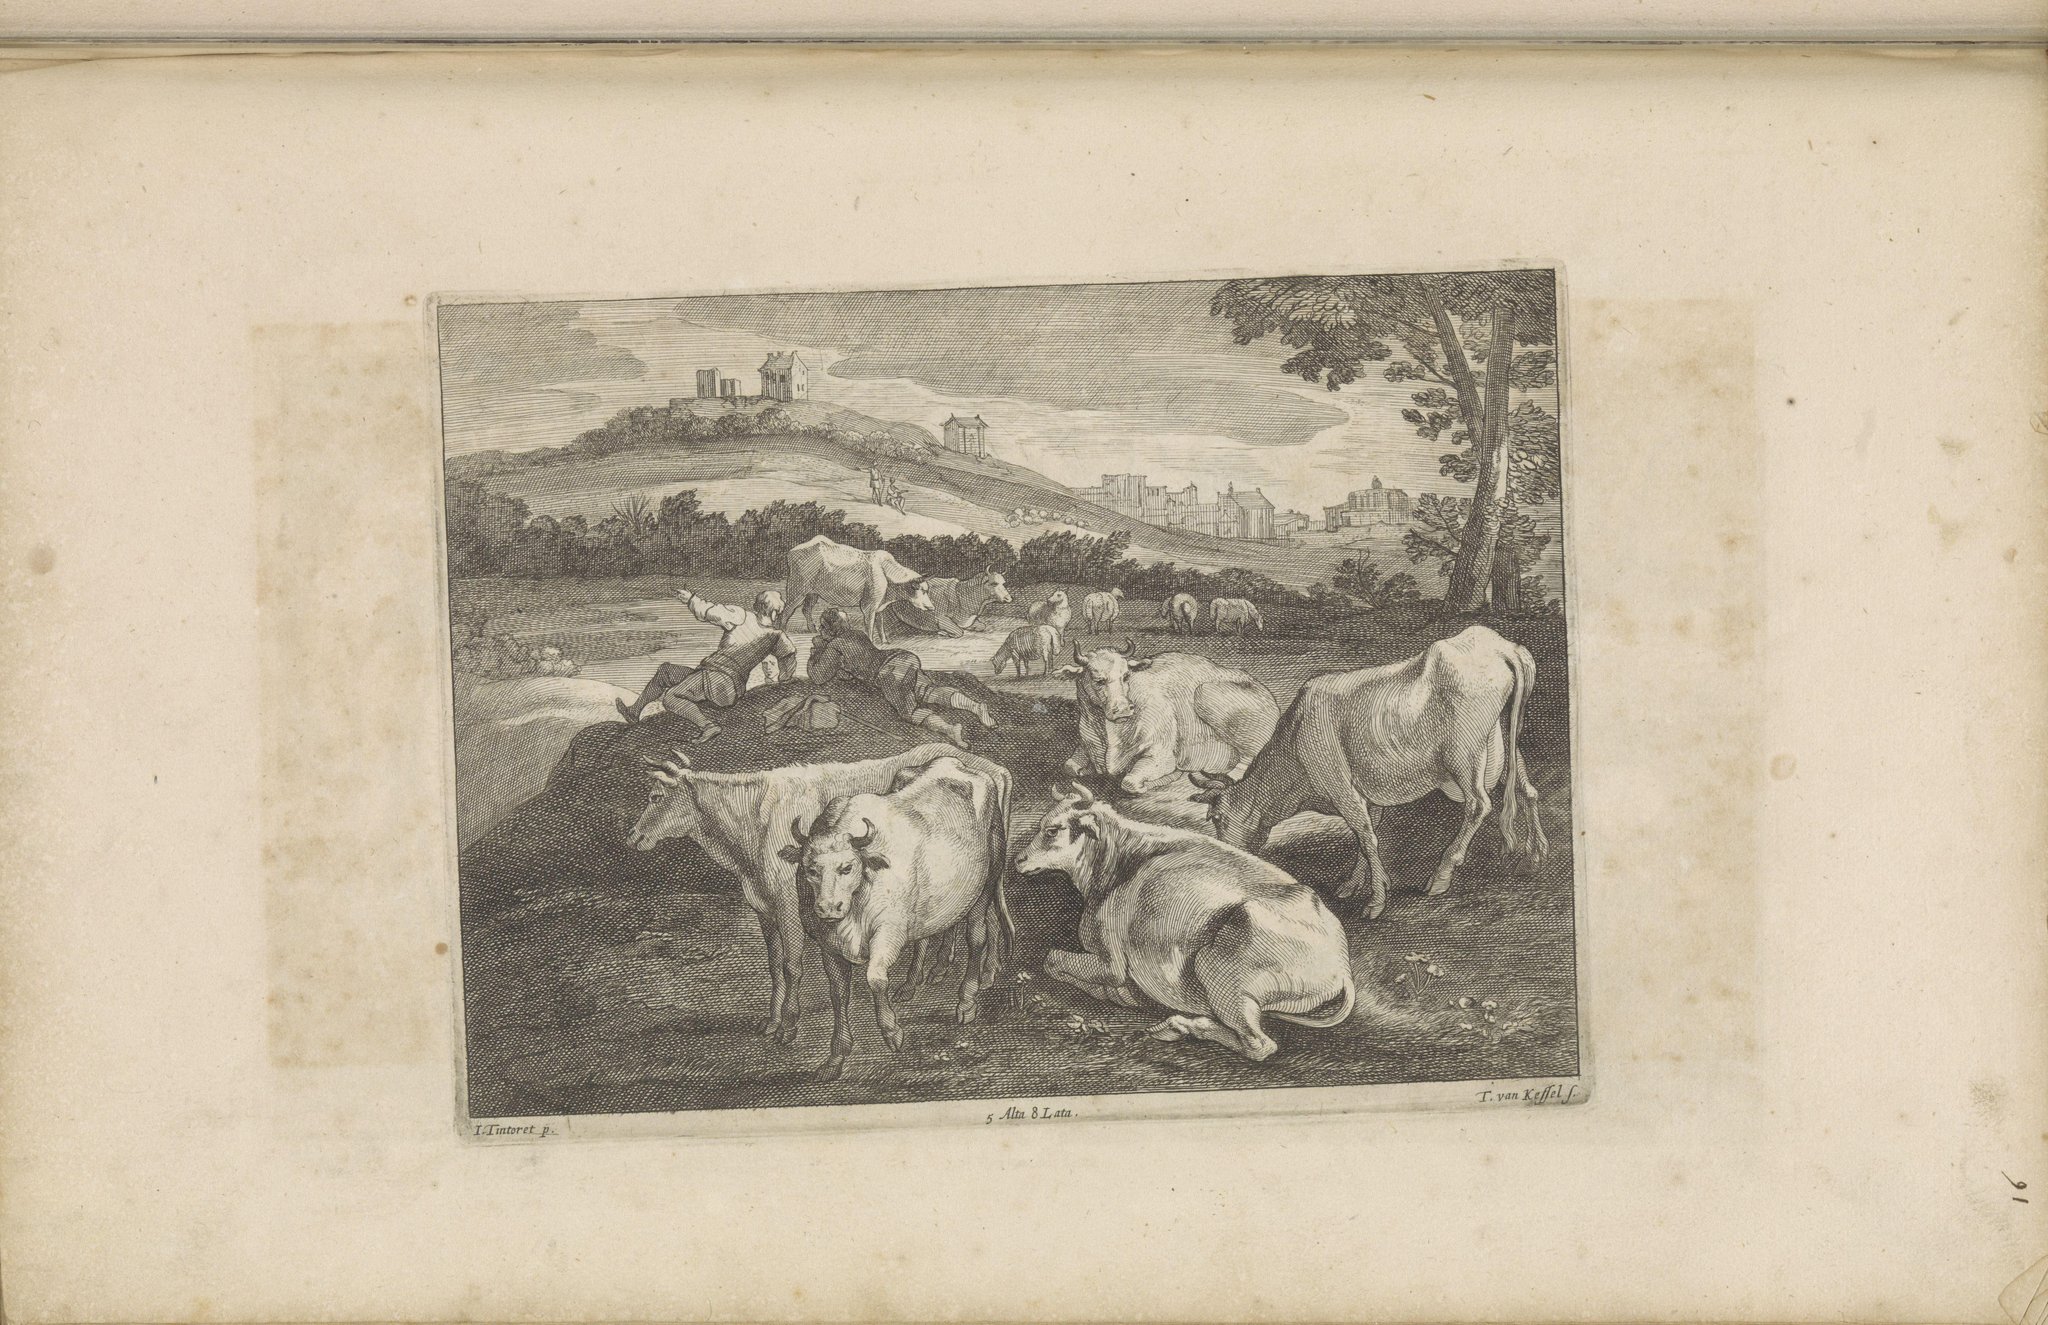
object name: album leaf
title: Kudde koeien in een heuvellandschap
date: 1660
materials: paper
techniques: etching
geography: southern netherlands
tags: low hill country, cow, herding, herdsman, herdswoman, shepherd, shepherdess, cowherd, etc.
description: David Teniers heeft waarschijnlijk van alle schilderijen uit de collectie van Leopold Willem van Oostenrijk een olieverfstudie op doek of paneel vervaardigd (zgn. pasticcio), die als voorbeeld voor de prentmakers diende. Het is niet altijd duidelijk of de pasticci door hem zijn gemaakt of door zijn atelier. Niet alle pasticci zijn overgeleverd.